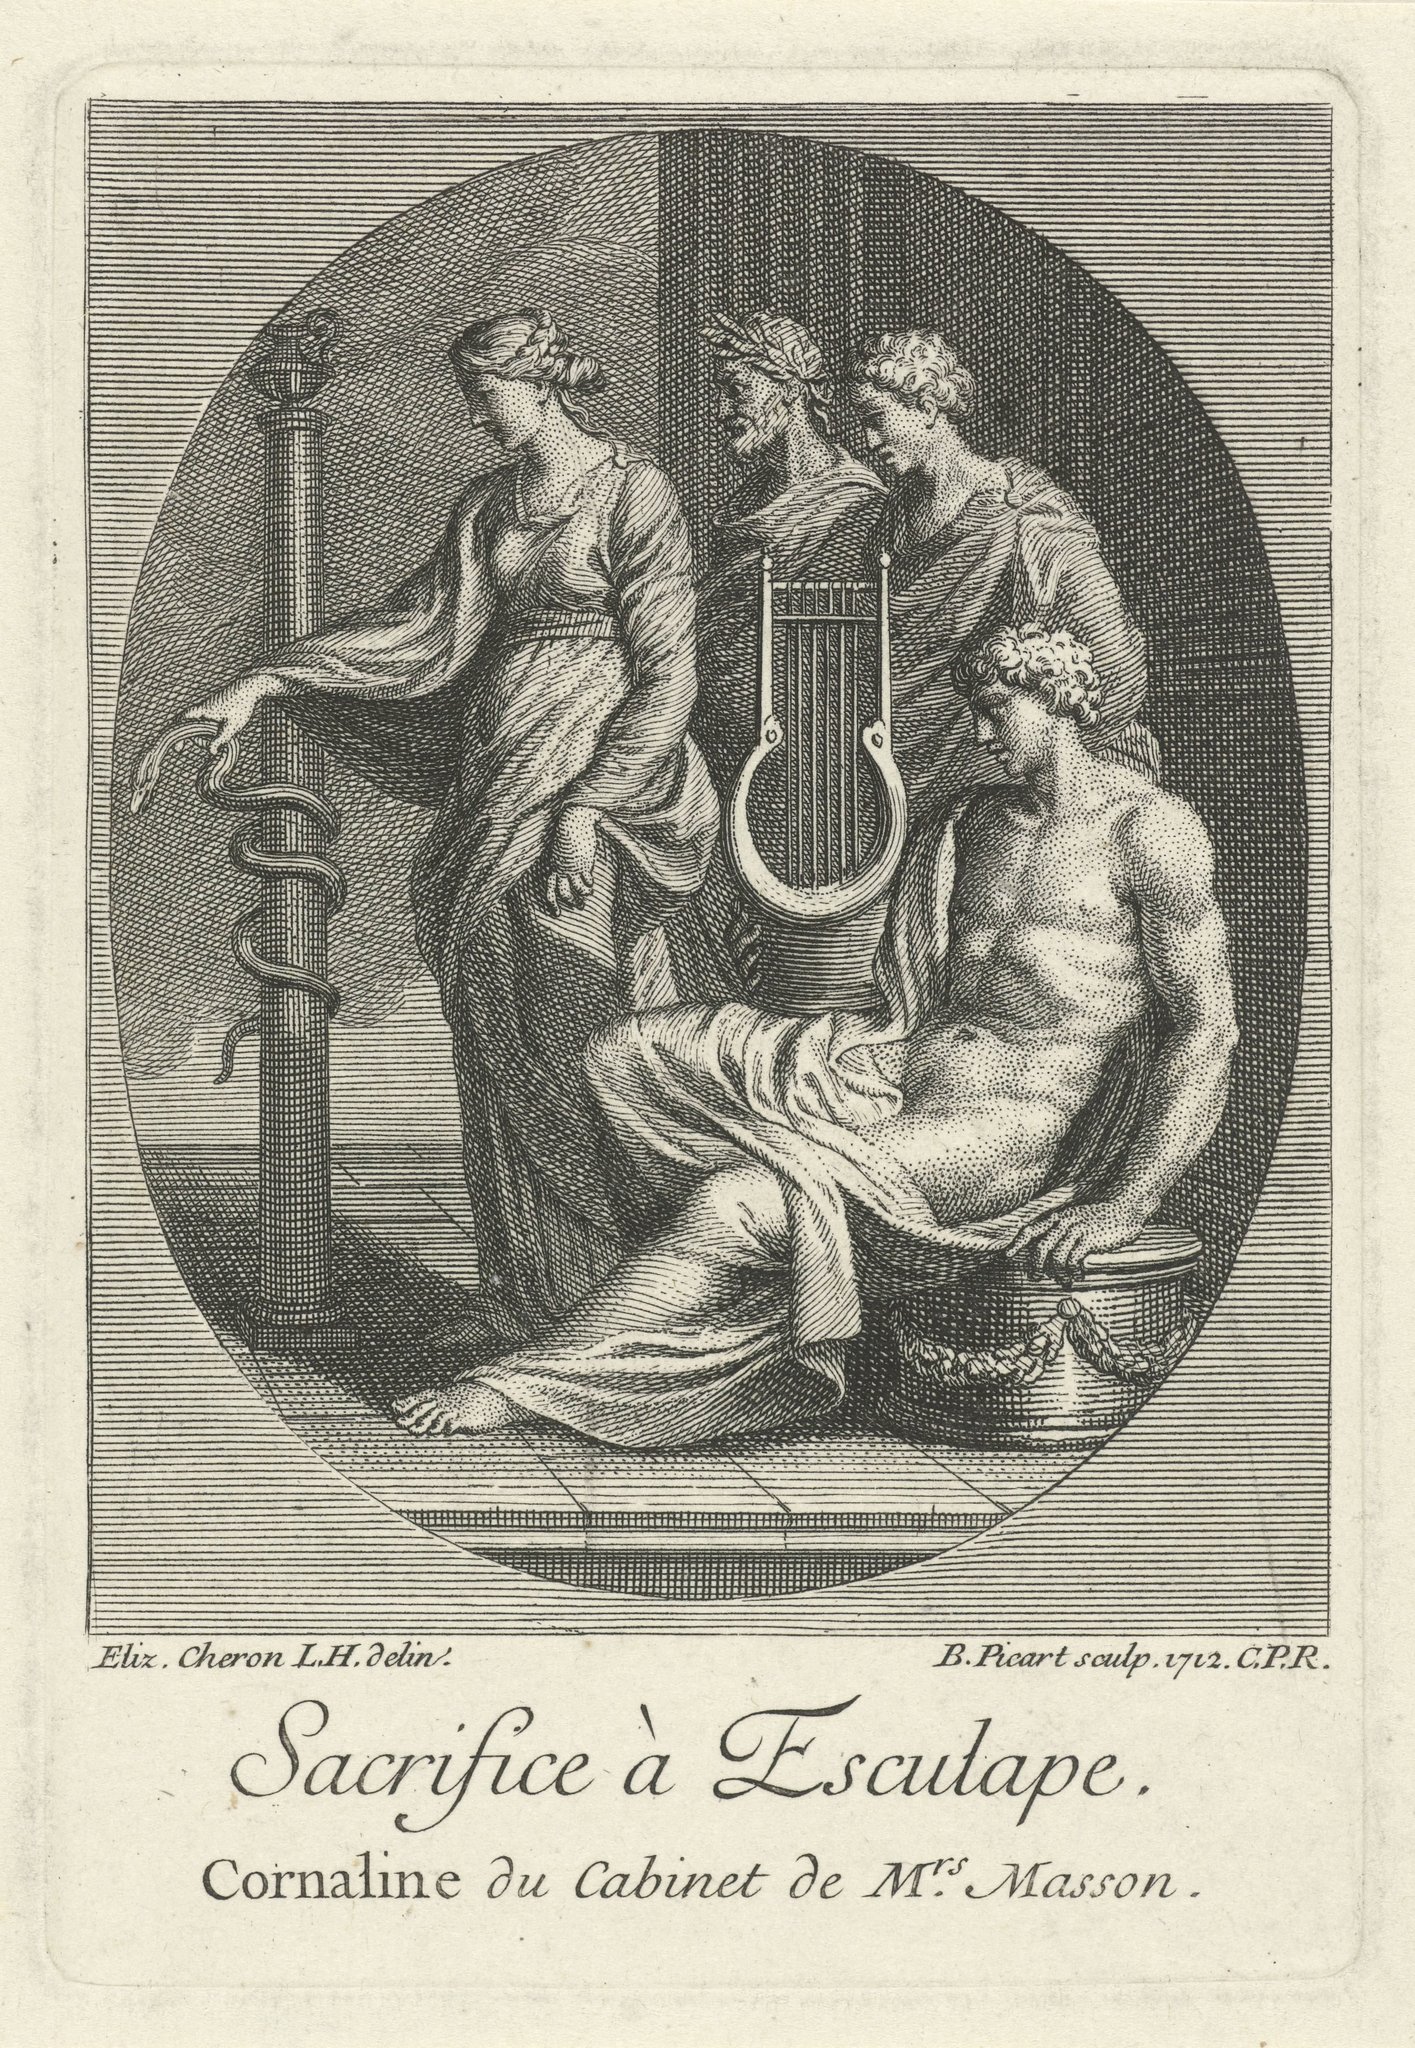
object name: print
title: Offer aan Aesculapius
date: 1712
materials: paper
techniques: engraving, etching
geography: paris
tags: aesculapian sign, sacrifice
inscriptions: collector's mark: Lugt 240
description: Een gezelschap brengt een offer bij de esculaap, het symbool van de god van de gezondheid en geneeskunst Aesculapius. Op de voorgrond zit een naakte jonge man op een voetstuk.